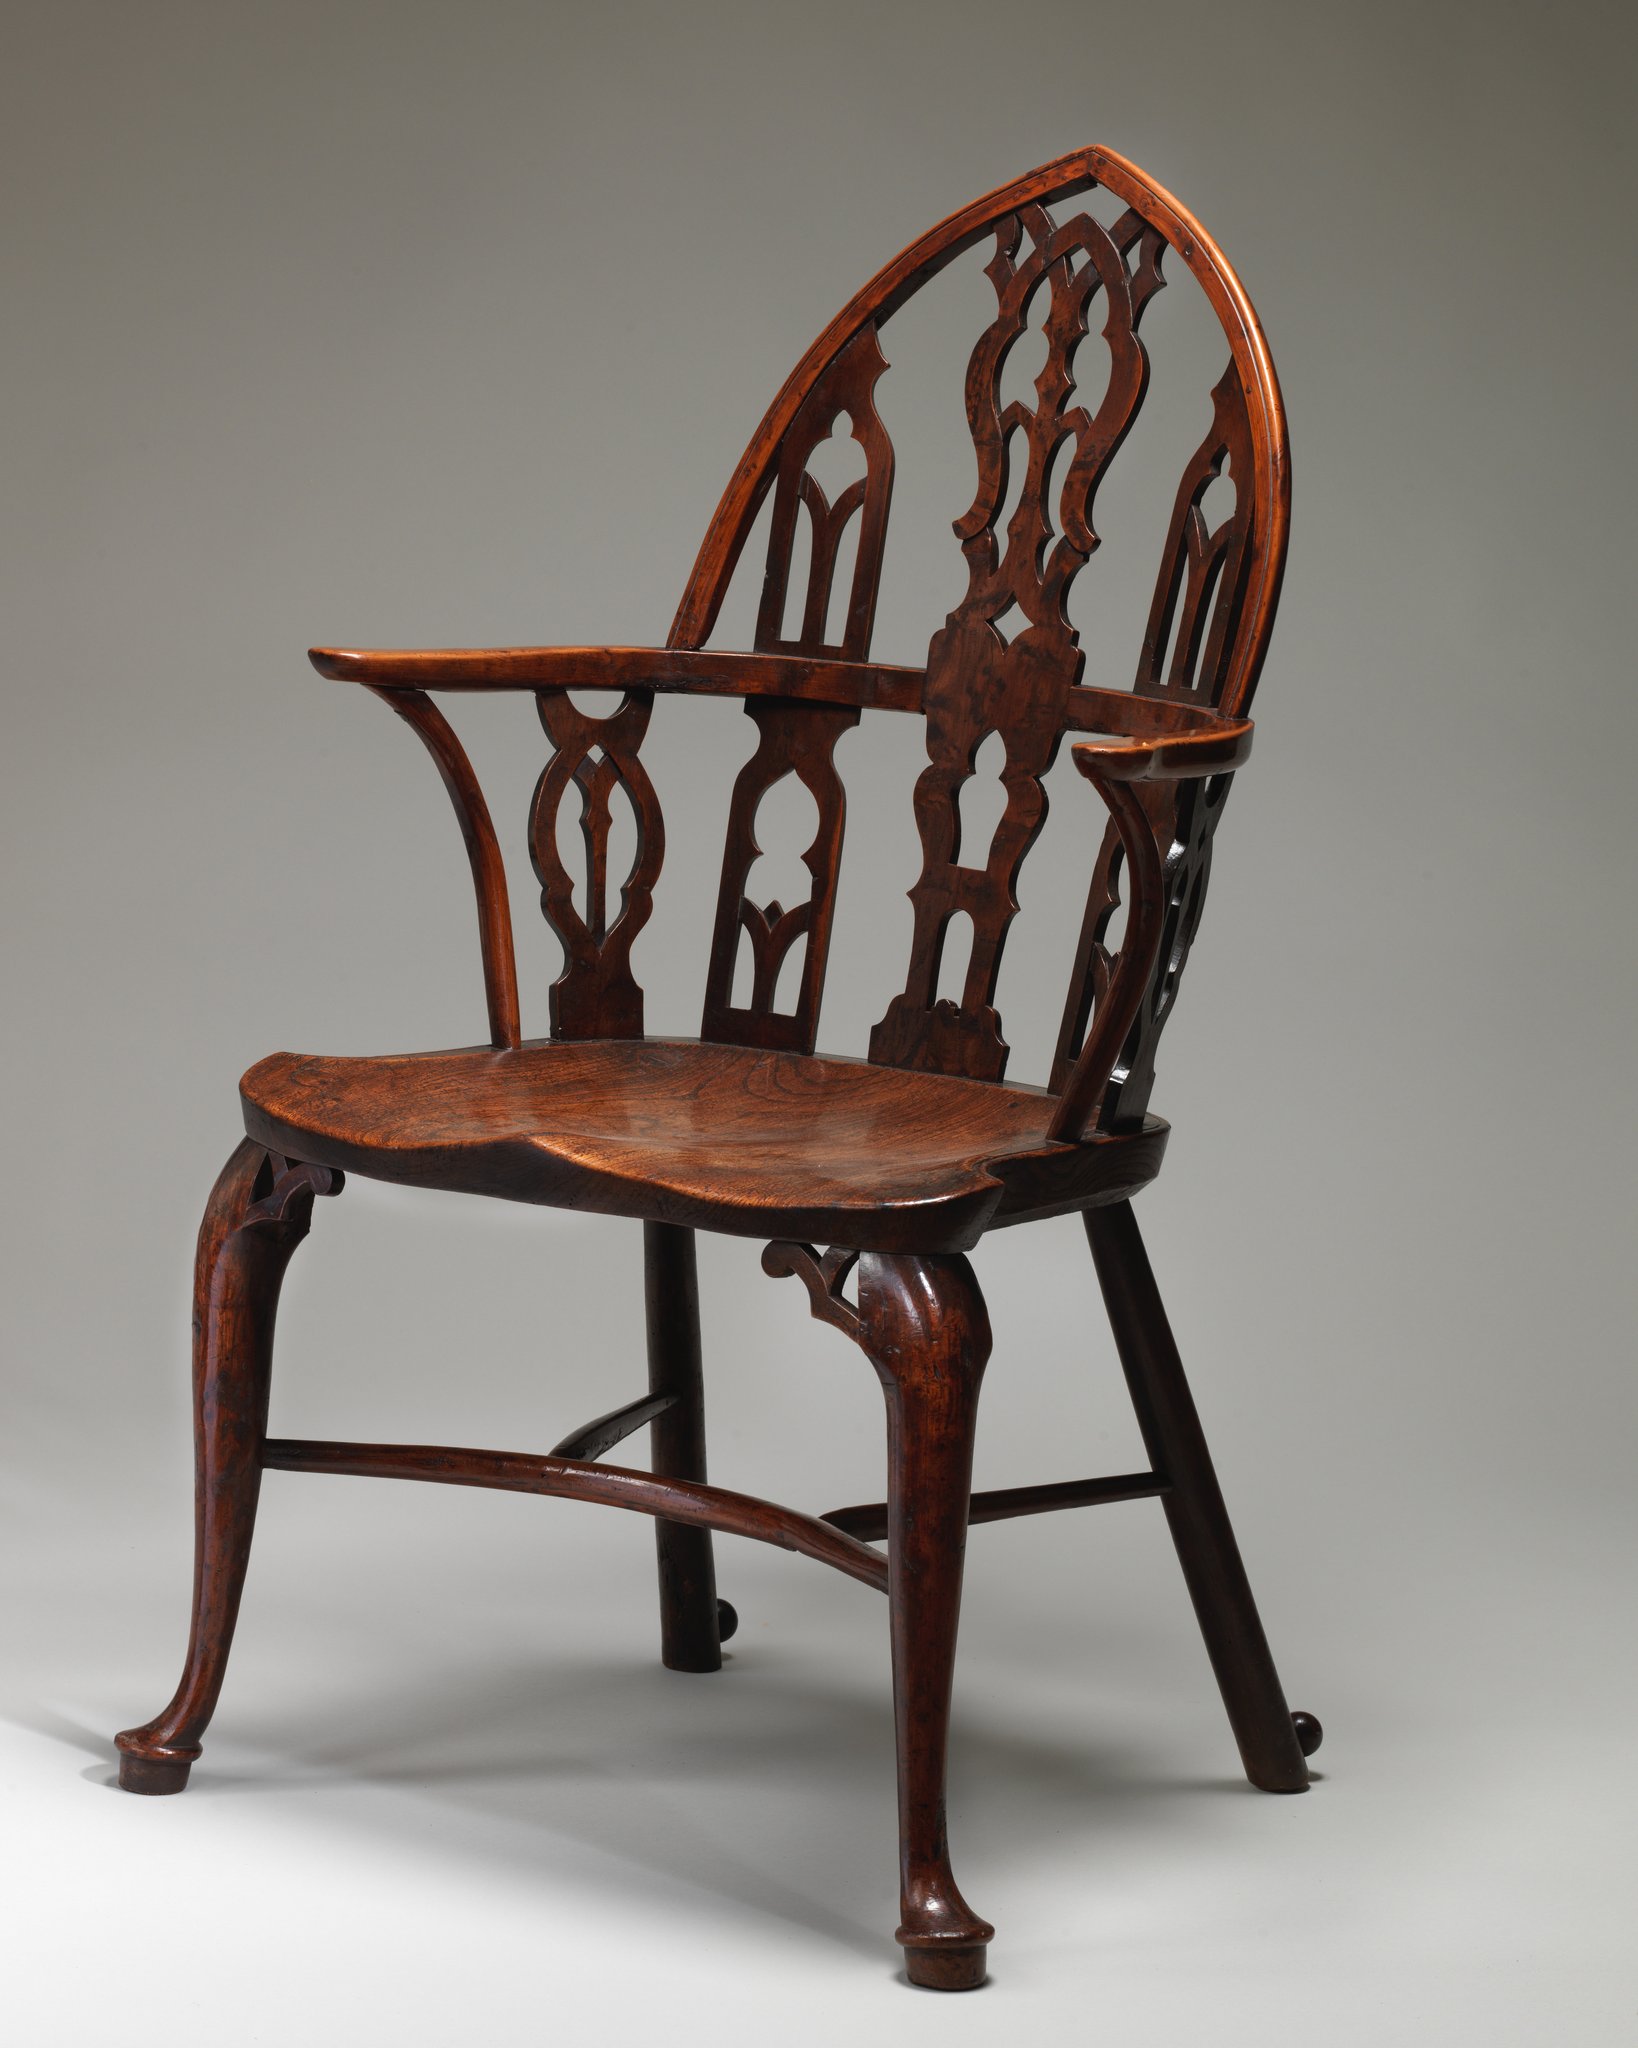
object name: armchair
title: Gothic Windsor armchair (one of a pair)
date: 1760-1769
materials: wood